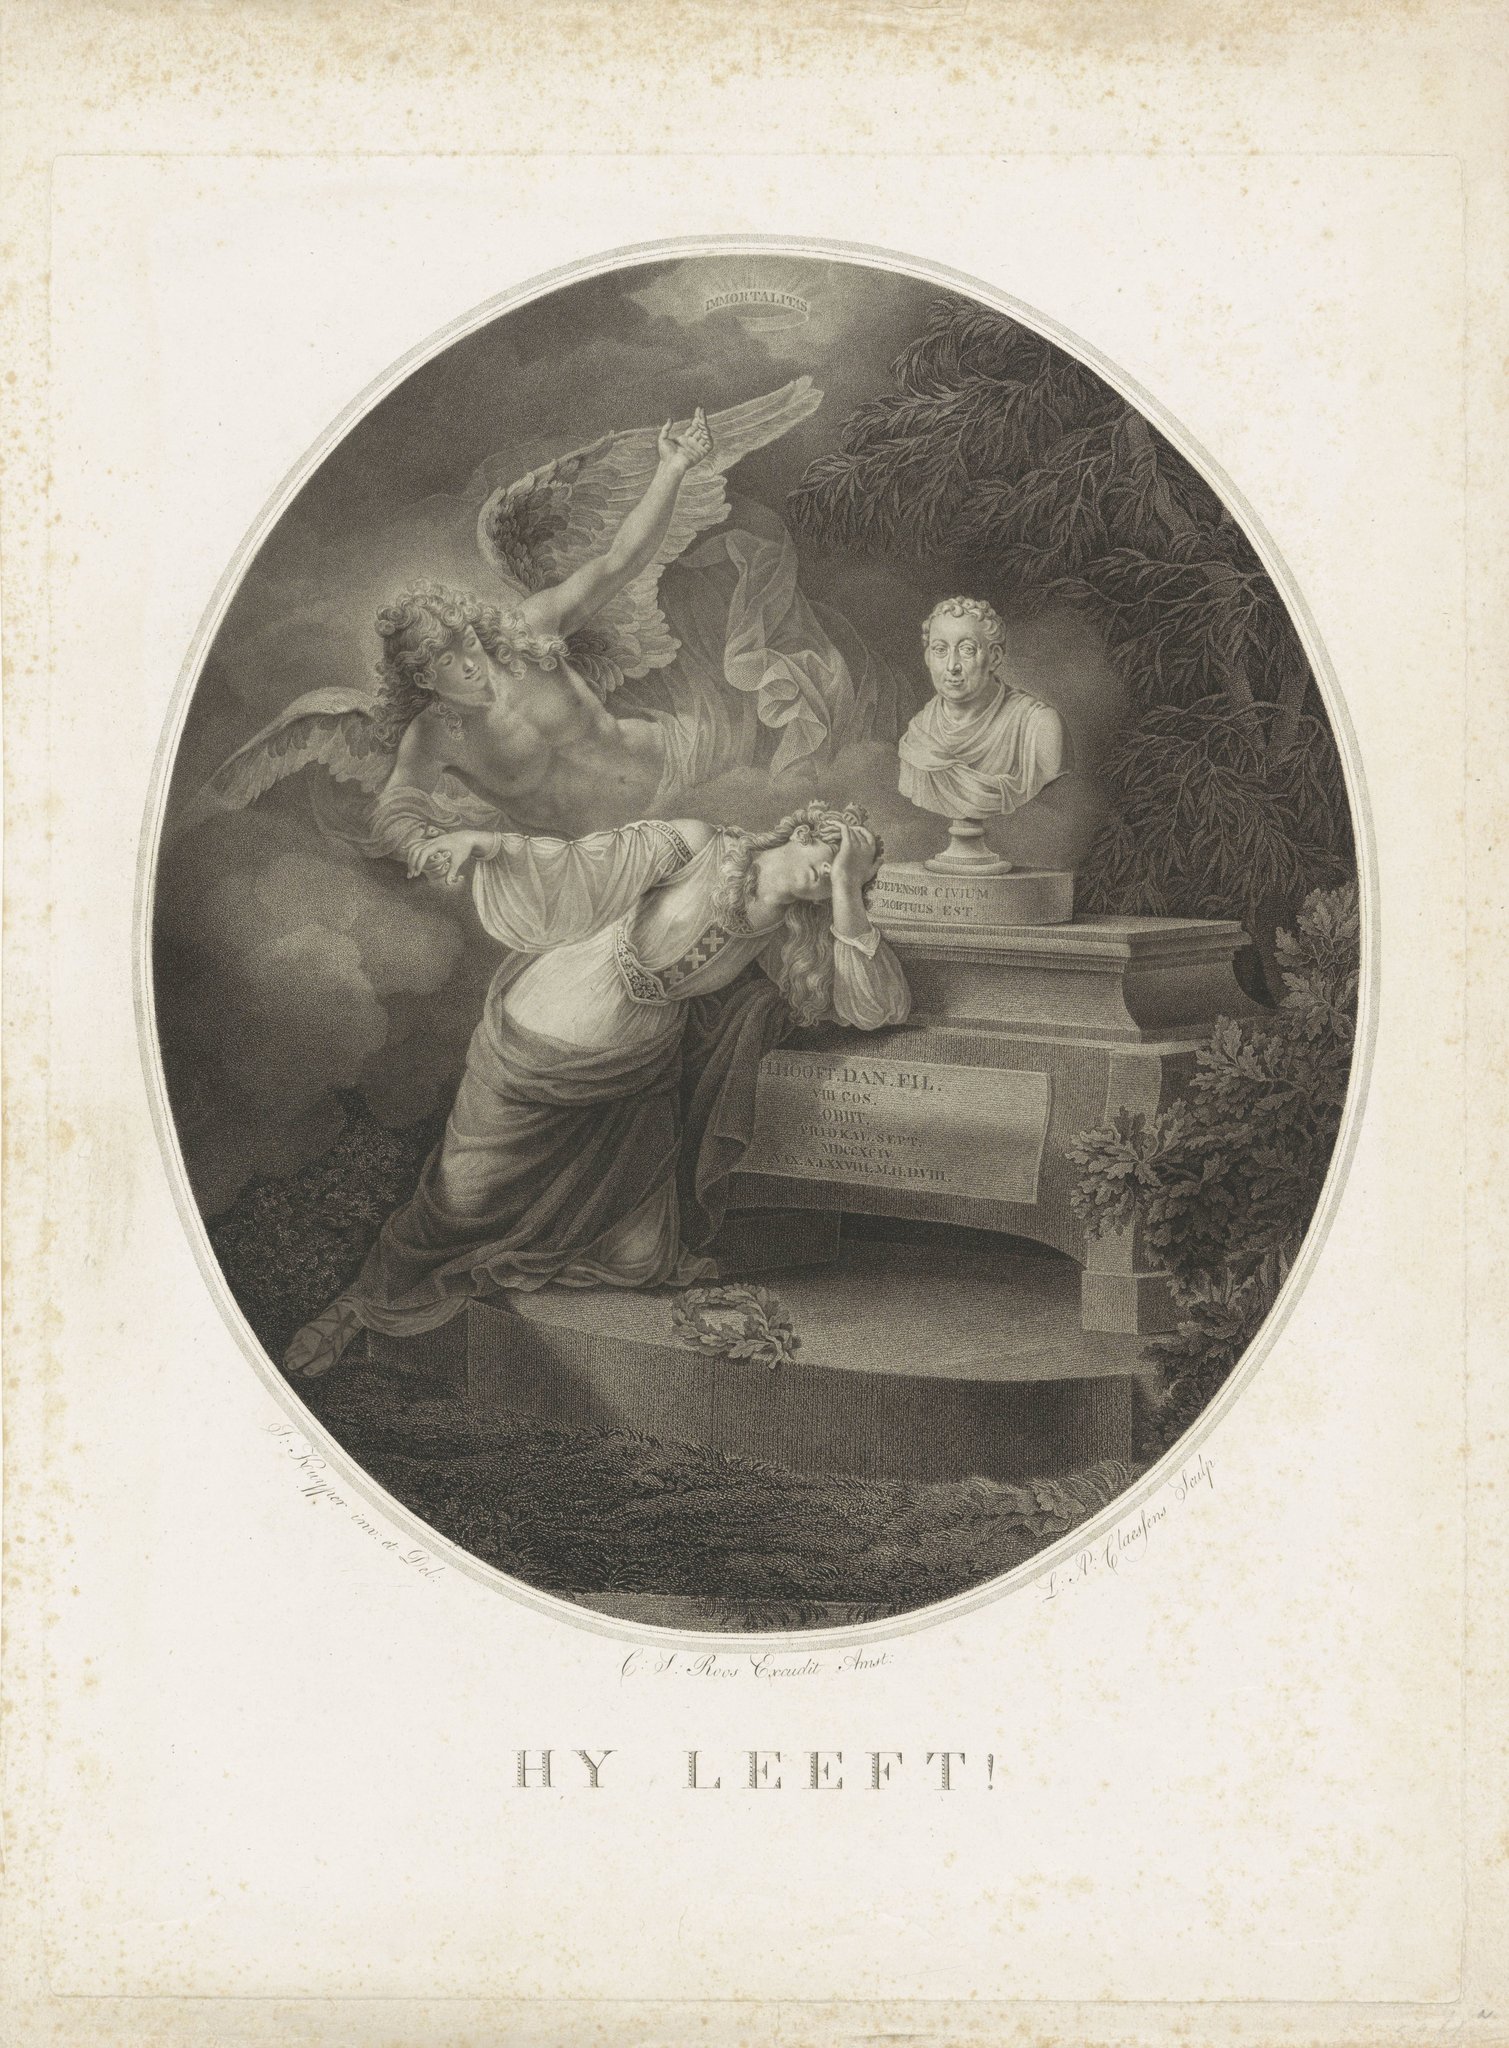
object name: print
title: Hy Leeft!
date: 1794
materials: paper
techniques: etching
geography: amsterdam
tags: amsterdam, mayor, hendrik danielsz. hooft, personification of a city, town-patron(ess), grave, tomb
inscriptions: inscription: ‘C: S: Roos’, collector's mark: Lugt 2228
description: Allegorisch grafmonument voor Hendrik Danielsz. Hooft, oud-burgemeester van Amsterdam, overleden op 31 augustus 1794. De stadsmaagd van Amsterdam treurend bij het graf wordt getroost door een engel die haar wijst op de door Hooft verworven 'Immortalitas' in de hemel.